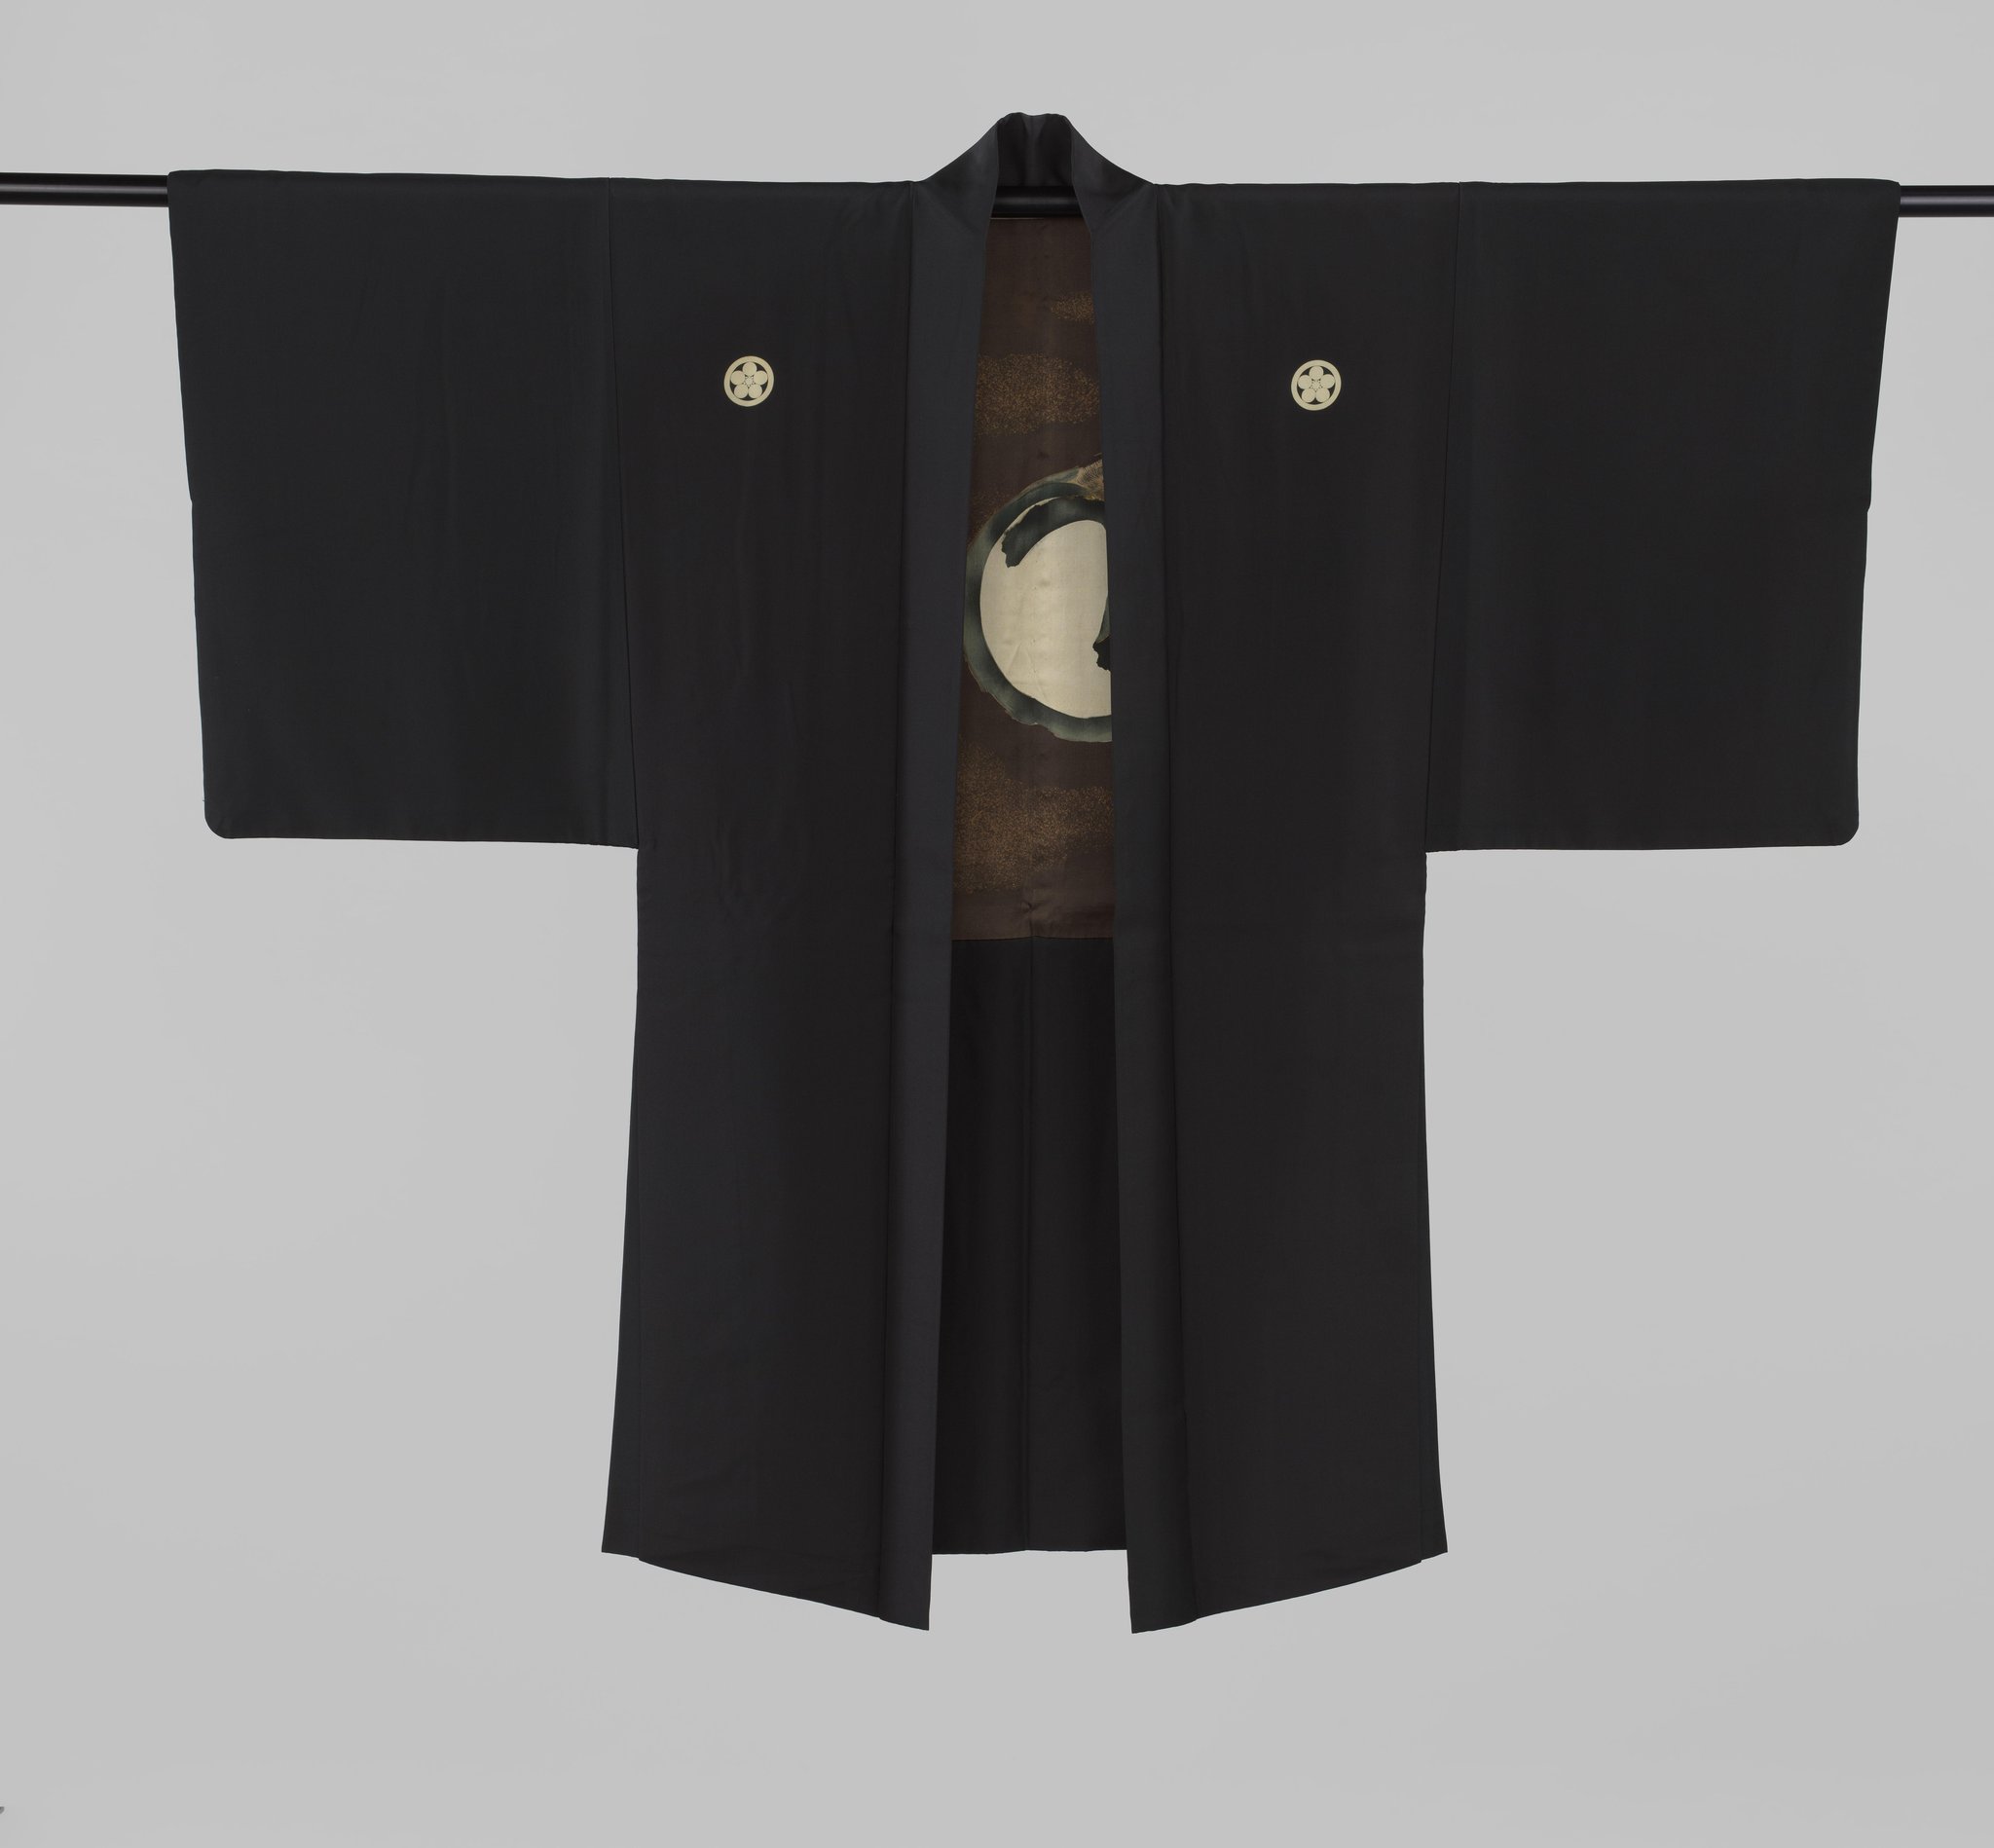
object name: kimono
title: Mannen haori met Daruma poppen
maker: Anonymous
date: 1920-1940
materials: silk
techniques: painting, weave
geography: japan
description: Kimonos: Mirrors of a Man’s Life. The kimonos on view here afford a glimpse into the lives of Japanese men from around the 1910s to the 1950s, from childhood to adulthood. This was a period of great change for Japan, marked by increasing industrialization and political conflicts culminating in the Second World War. Life modernized, technology advanced, and people took up new hobbies. Traditionally, men’s outer clothing tended to be reserved and a solid colour. Clothes could nevertheless also be a medium for highly unusual depictions which, however, were not visible to everyone. While motifs adorned the exterior of children’s garments, they were hidden from view in those worn by adult men. The decoration was found on the inside: on a long under garment, or the lining of a jacket (haori). This concealed imagery divulges the lives of the owners at the beginning of the 20th century. Childhood. A kimono marked events and stages in a man’s life. The kimonos on the top row (except the two everyday ones at either end) were worn by boys during the religious ceremony of miyamairi, namely an infant’s first visit to a Shinto shrine. This event followed a prescribed ritual and was an important and formative moment in the life of a Japanese man. Clothing for boys enveloped them in images that were to become part of their identity. The depictions included motifs that were considered gender and age appropriate: toys, manly hobbies, stories of heroic battles, technology, and so forth. Broader themes such as military conflicts and nationalism also filtered into children’s daily lives at an early stage. The textile designs of some kimonos combined traditional playthings with toy guns and tanks. Adulthood. What does a kimono tell about its owner and his life? Some men chose subjects from classical culture, such as No or Kabuki theatre, while others preferred themes from contemporary life, such as gramophone records or the new popular sport of baseball. Thus, these garments were a canvas for personal choices, but also for political propaganda and nationalistic messages. Some representations are eccentric or even erotic. Others are more general and linked to political events. All aspects of a man’s inner life are touched on. Portraits of beautiful women and playful dogs contrast with images of war, celebrating victories in China. As these representations were under the outer garments, they remained hidden from the outside world and were thus seen only by the kimono’s owner and his intimates.